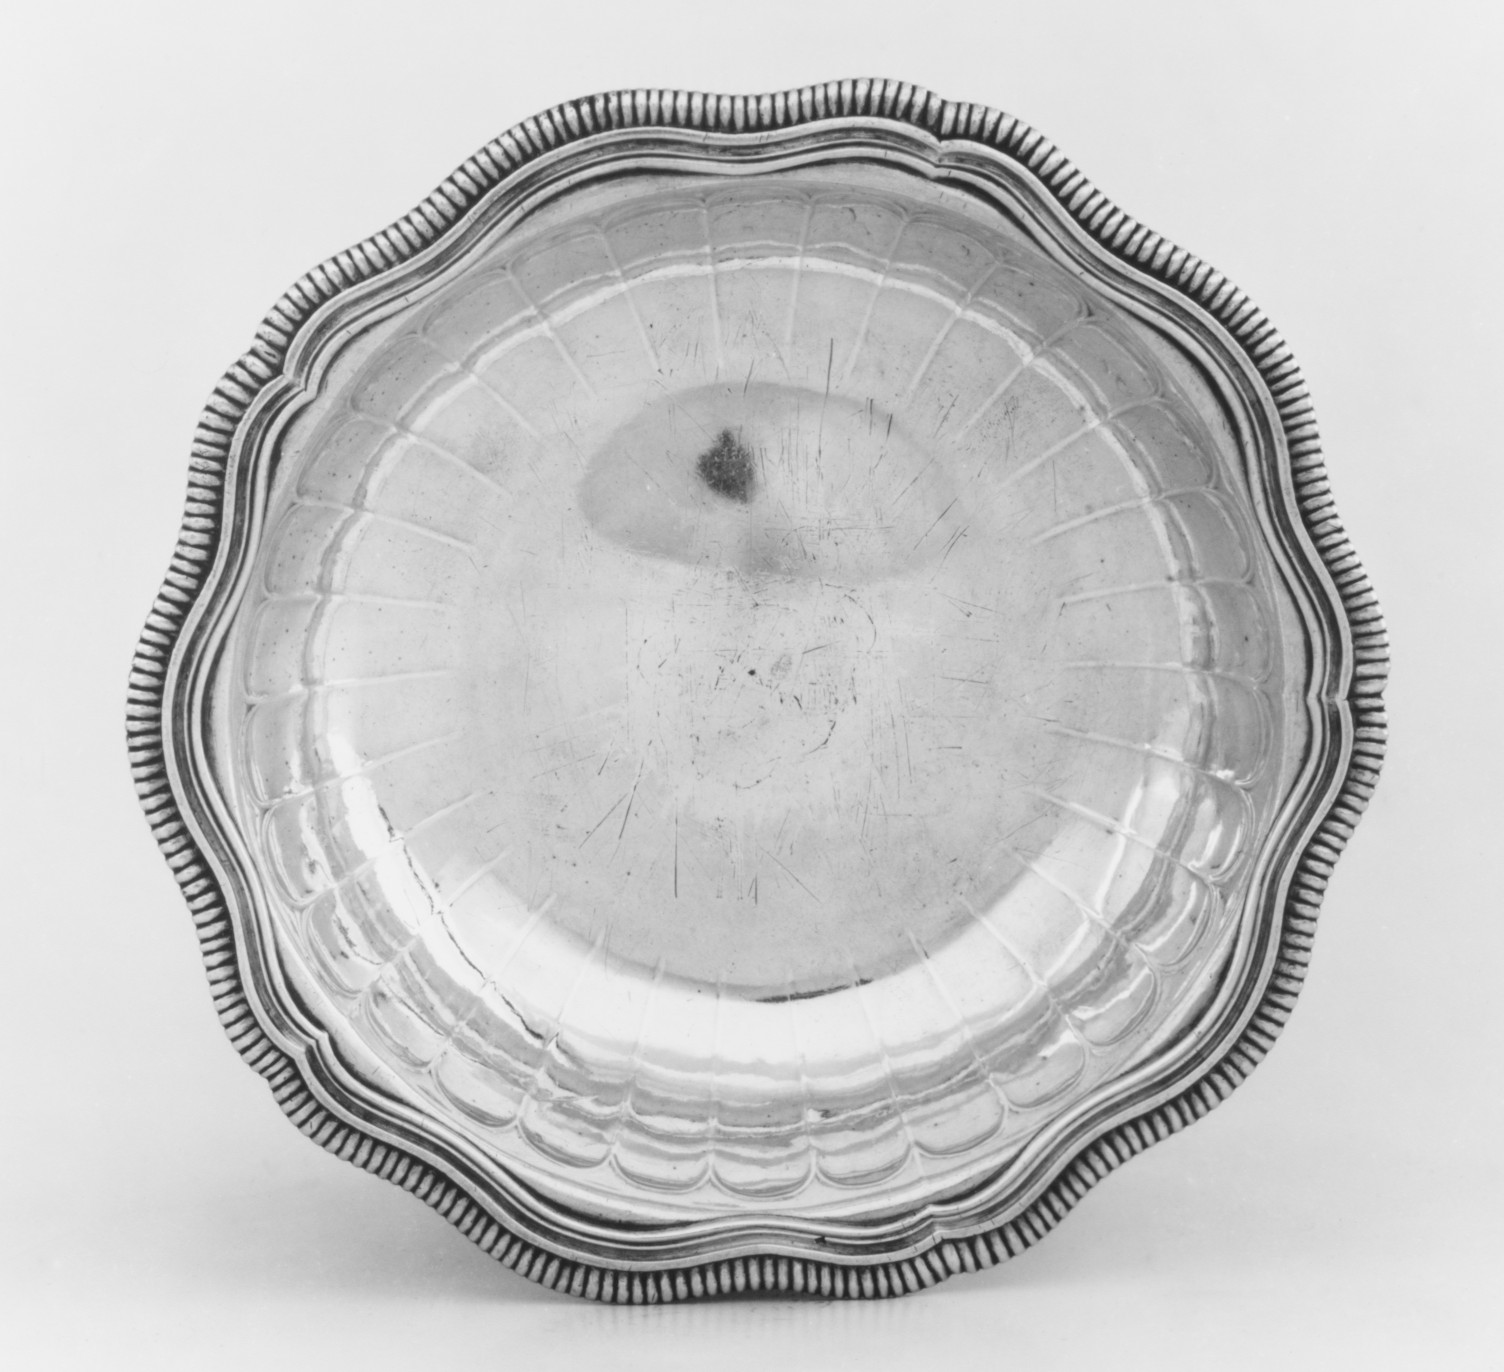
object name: dish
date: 1735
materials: silver